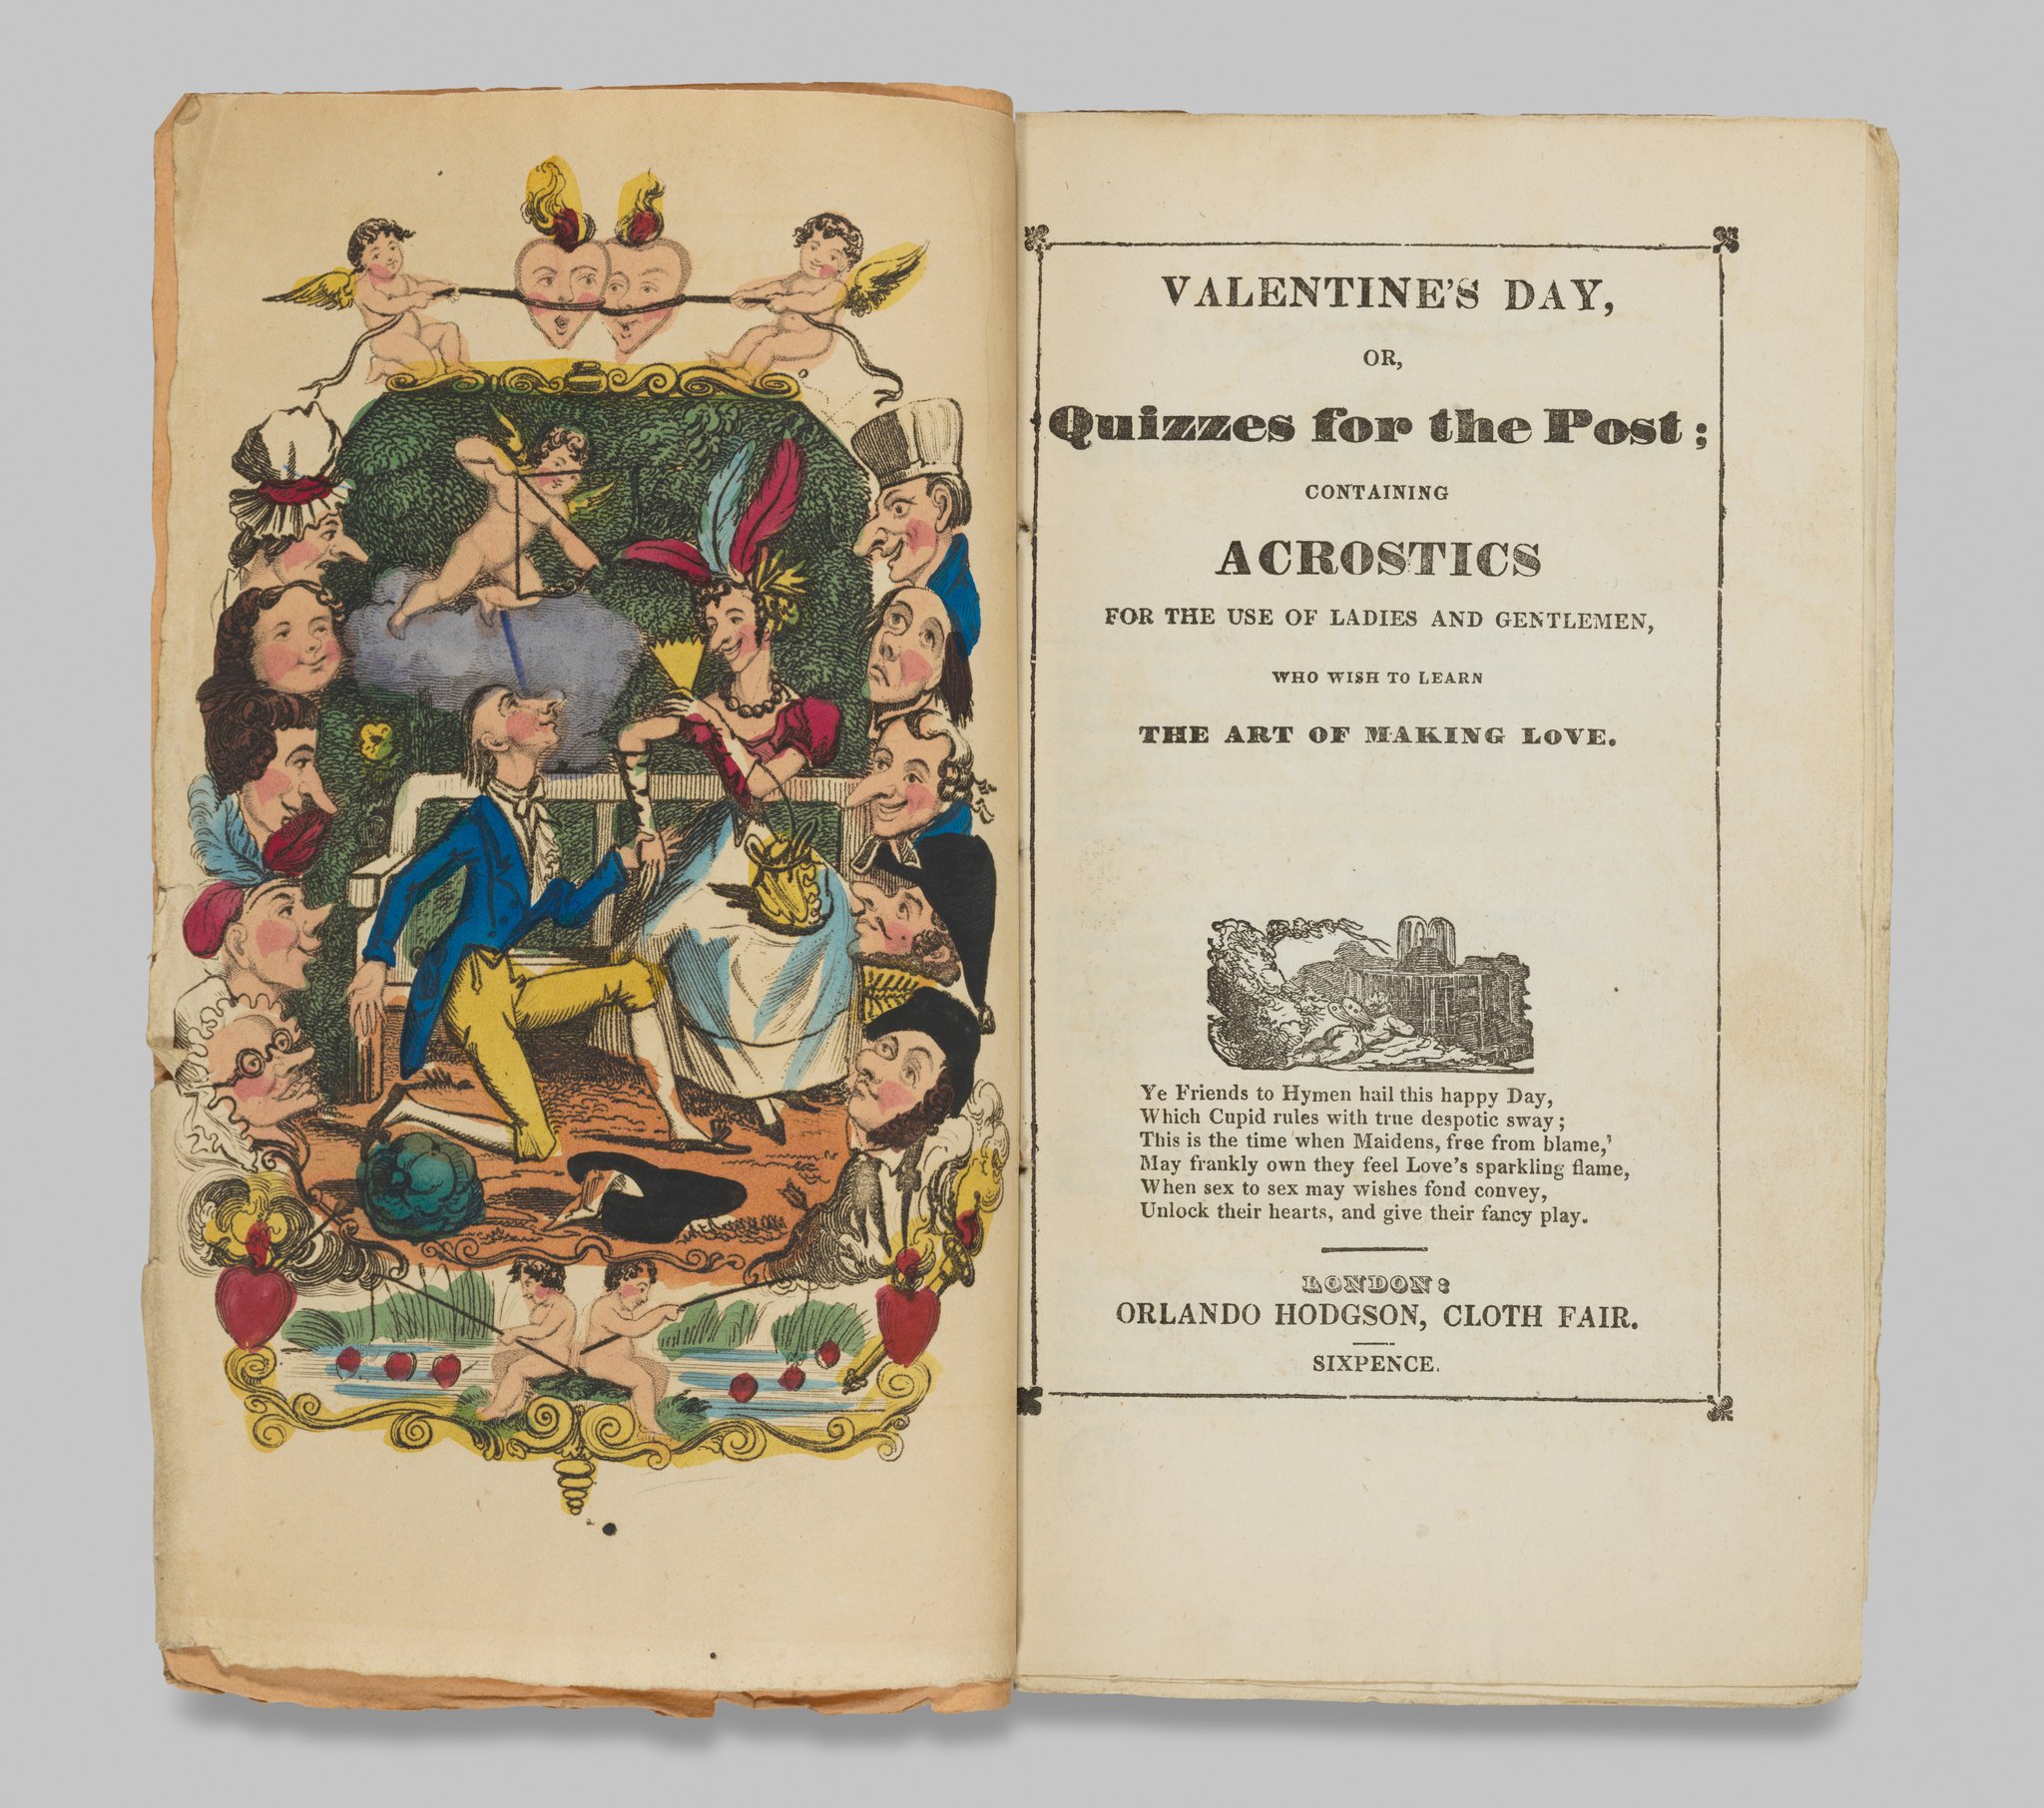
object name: book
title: Valentine's Day, or Quizzes for the Post; Containing Acrostics for the Use of Ladies and Gentlemen, Who Wish to Learn the Art of Making Love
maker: orlando hodgson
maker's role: publisher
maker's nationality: british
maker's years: 1810-1850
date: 1830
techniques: etching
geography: england